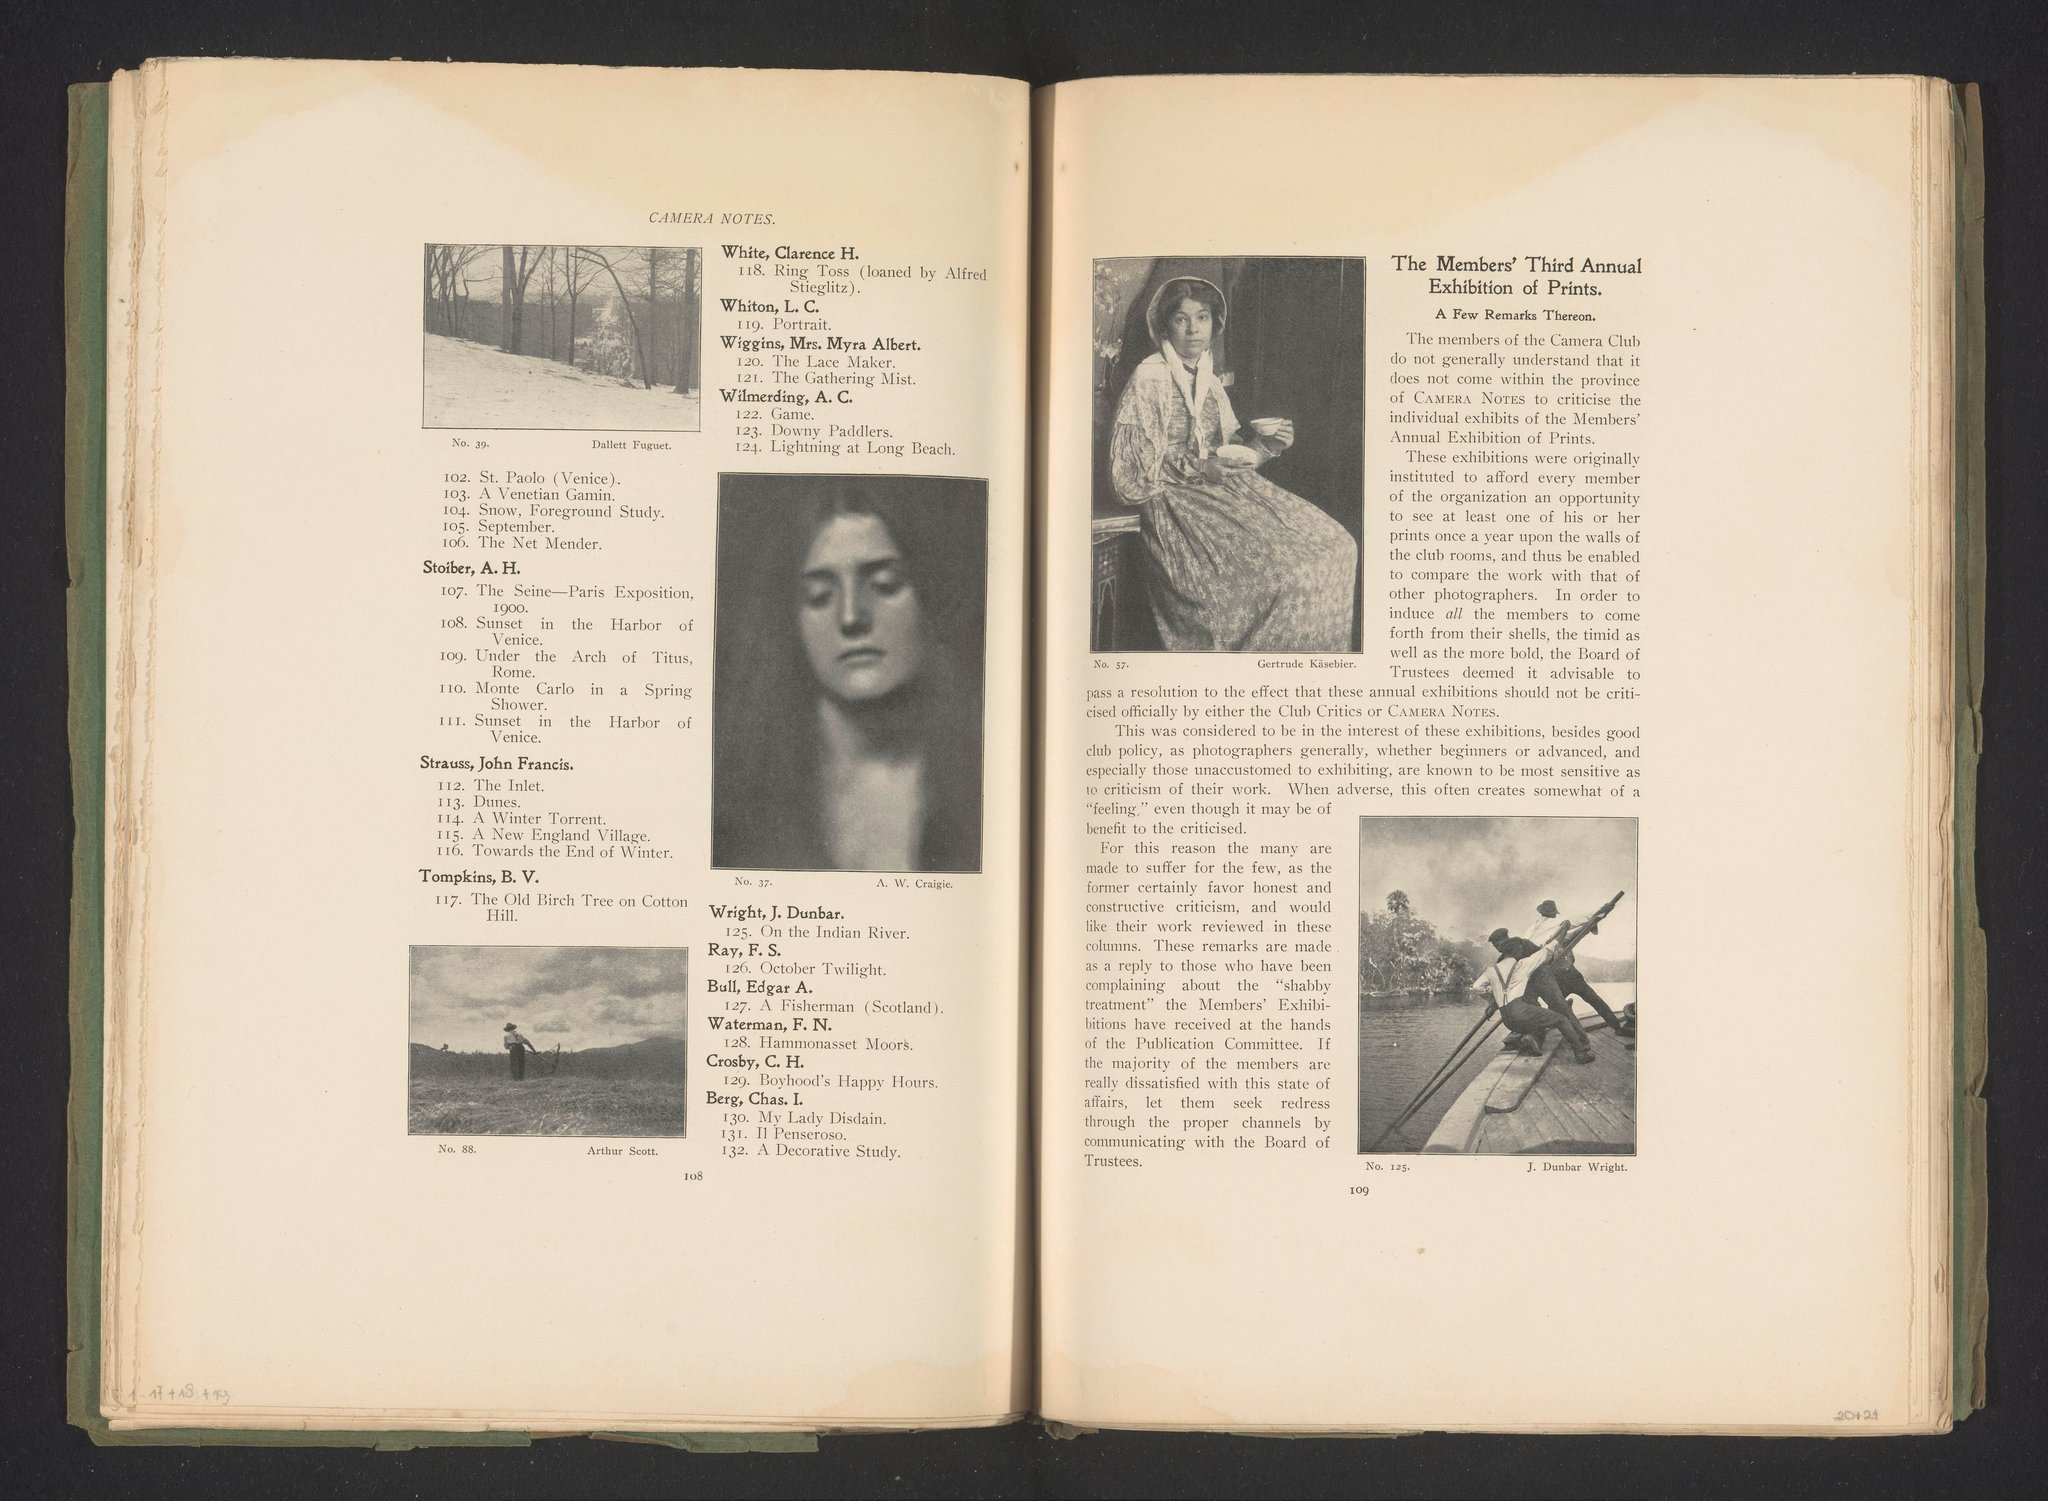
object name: page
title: Winterlandschap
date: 1895-1900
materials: paper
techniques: autotype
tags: landscapes, snow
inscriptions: number: ‘No. 39’